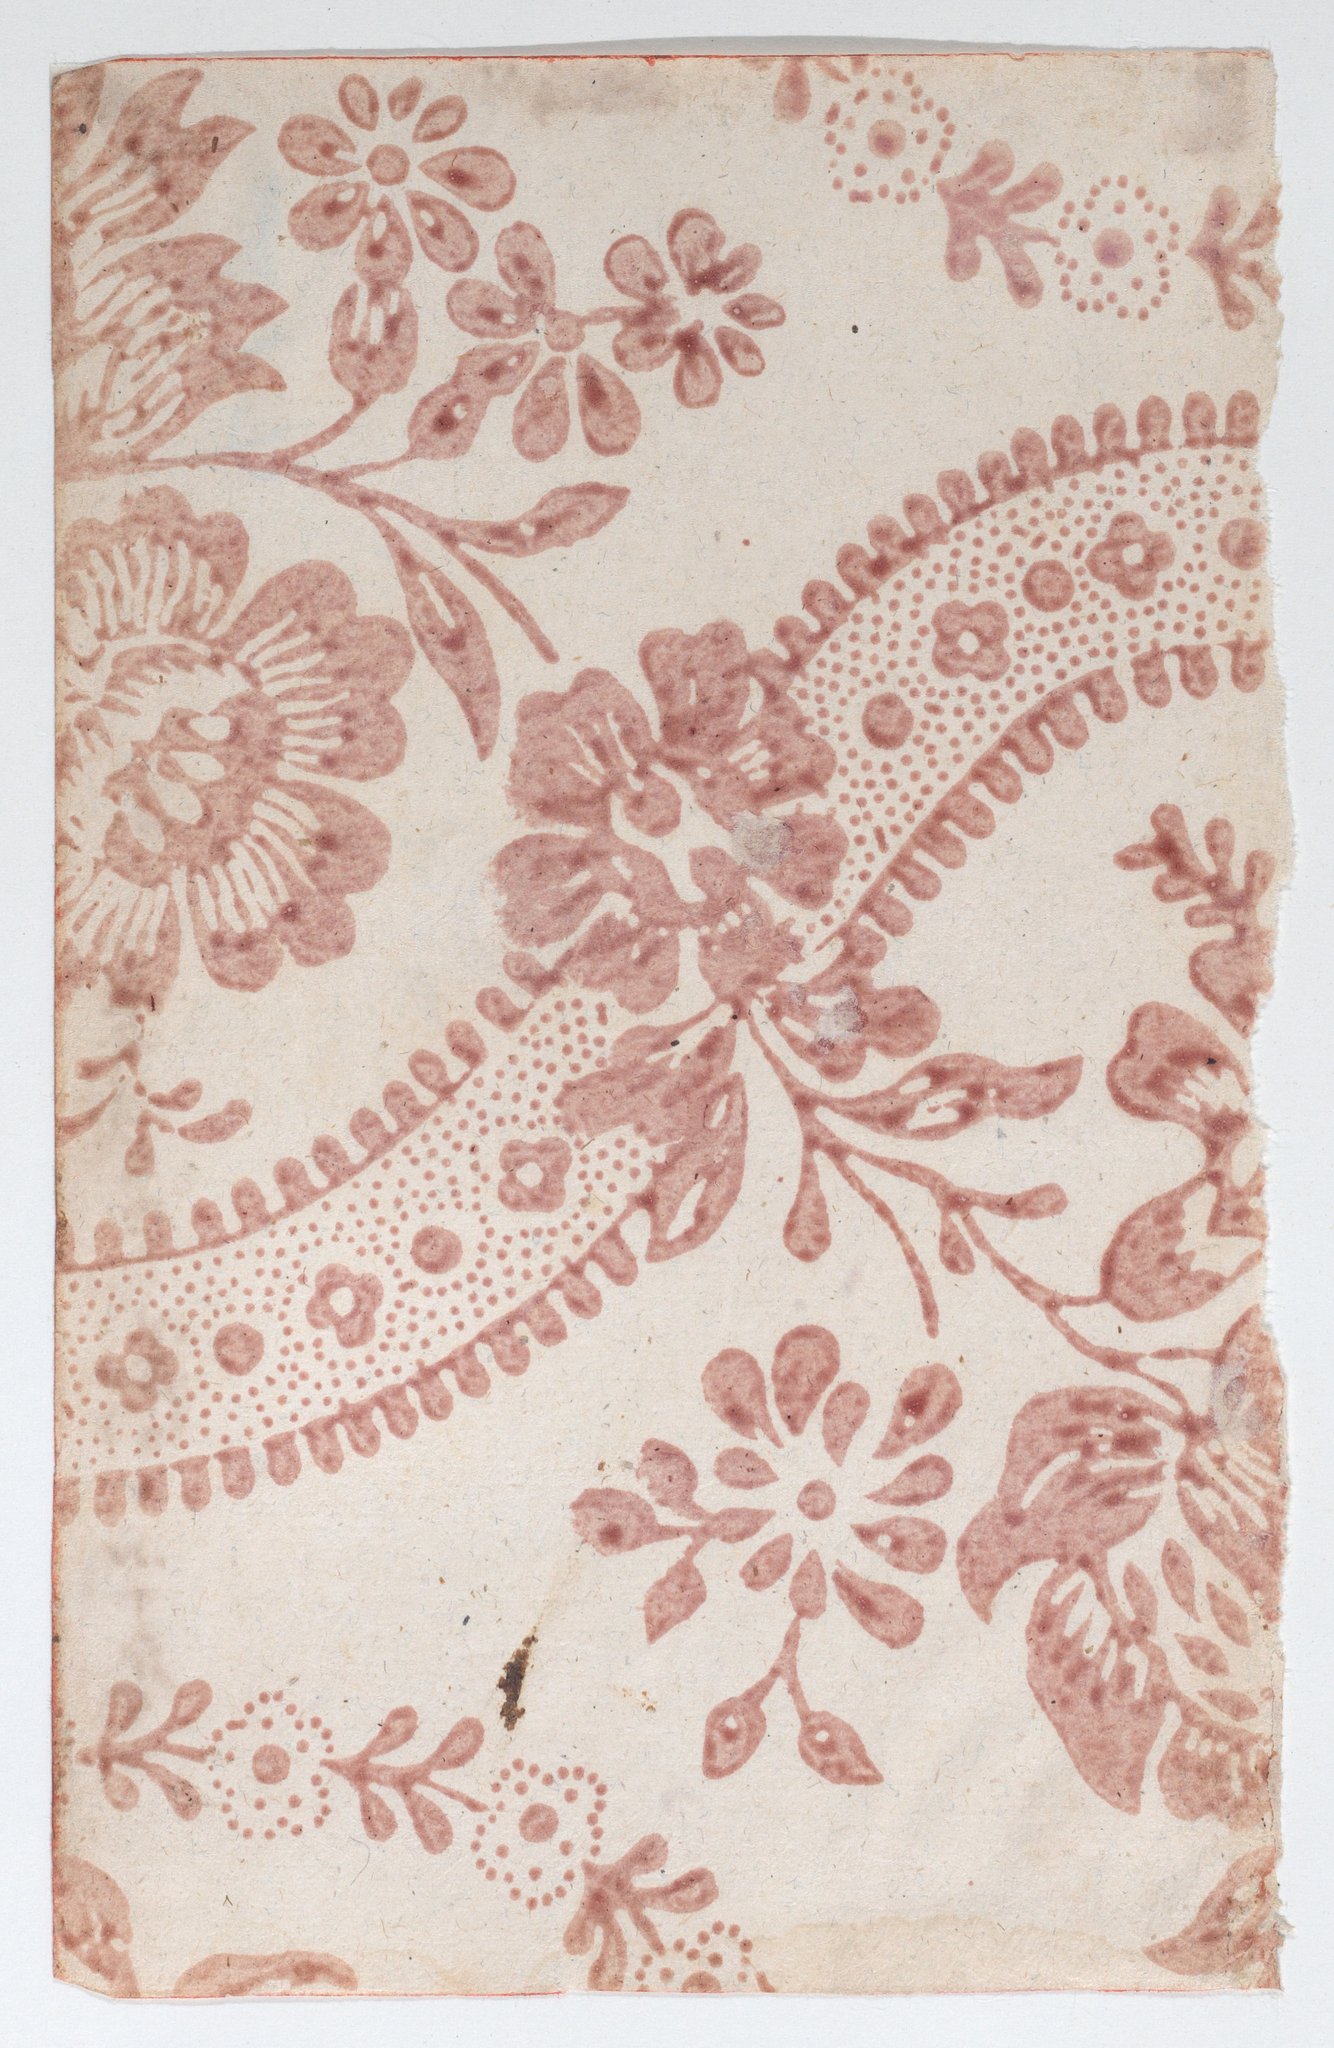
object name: print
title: Sheet with overall red floral pattern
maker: Anonymous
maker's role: artist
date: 1801-1900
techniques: relief print